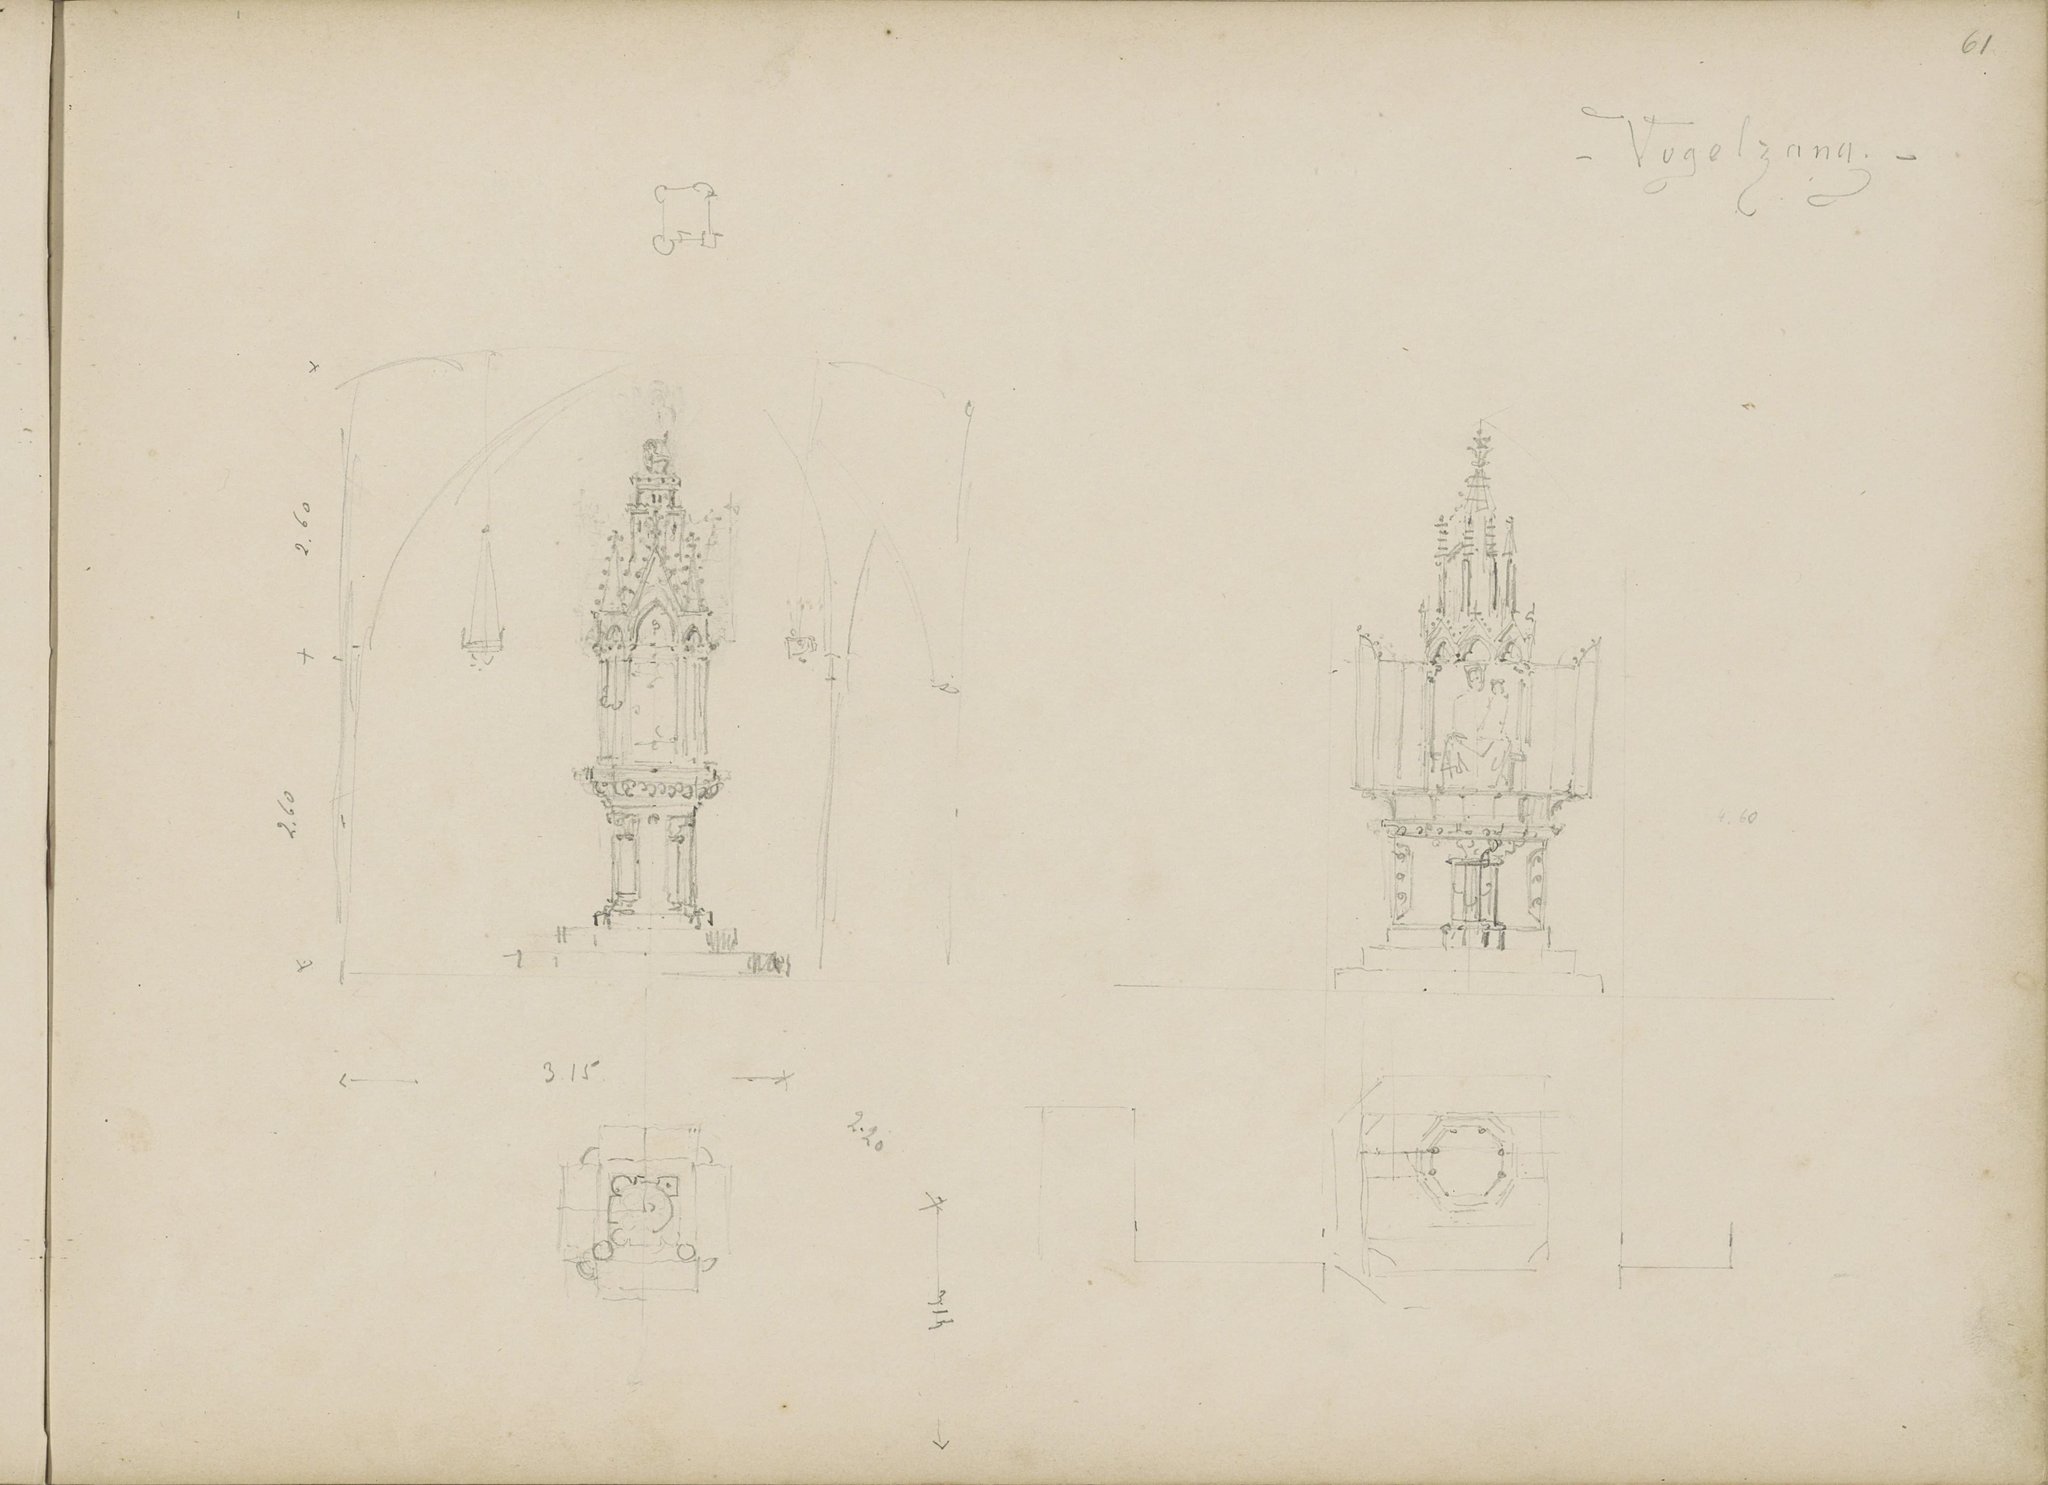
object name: sketchbook leaf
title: Onze-Lieve-Vrouwe troon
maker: pierre joseph hubert cuypers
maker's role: draughtsman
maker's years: 1827-1921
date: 1857-1859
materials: paper, pencil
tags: altar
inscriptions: annotation: ‘Vogelzang/ [...]’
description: Ontwerp voor een altaar met openslaande deuren. Blad 61 recto uit een schetsboek met 77 bladen.